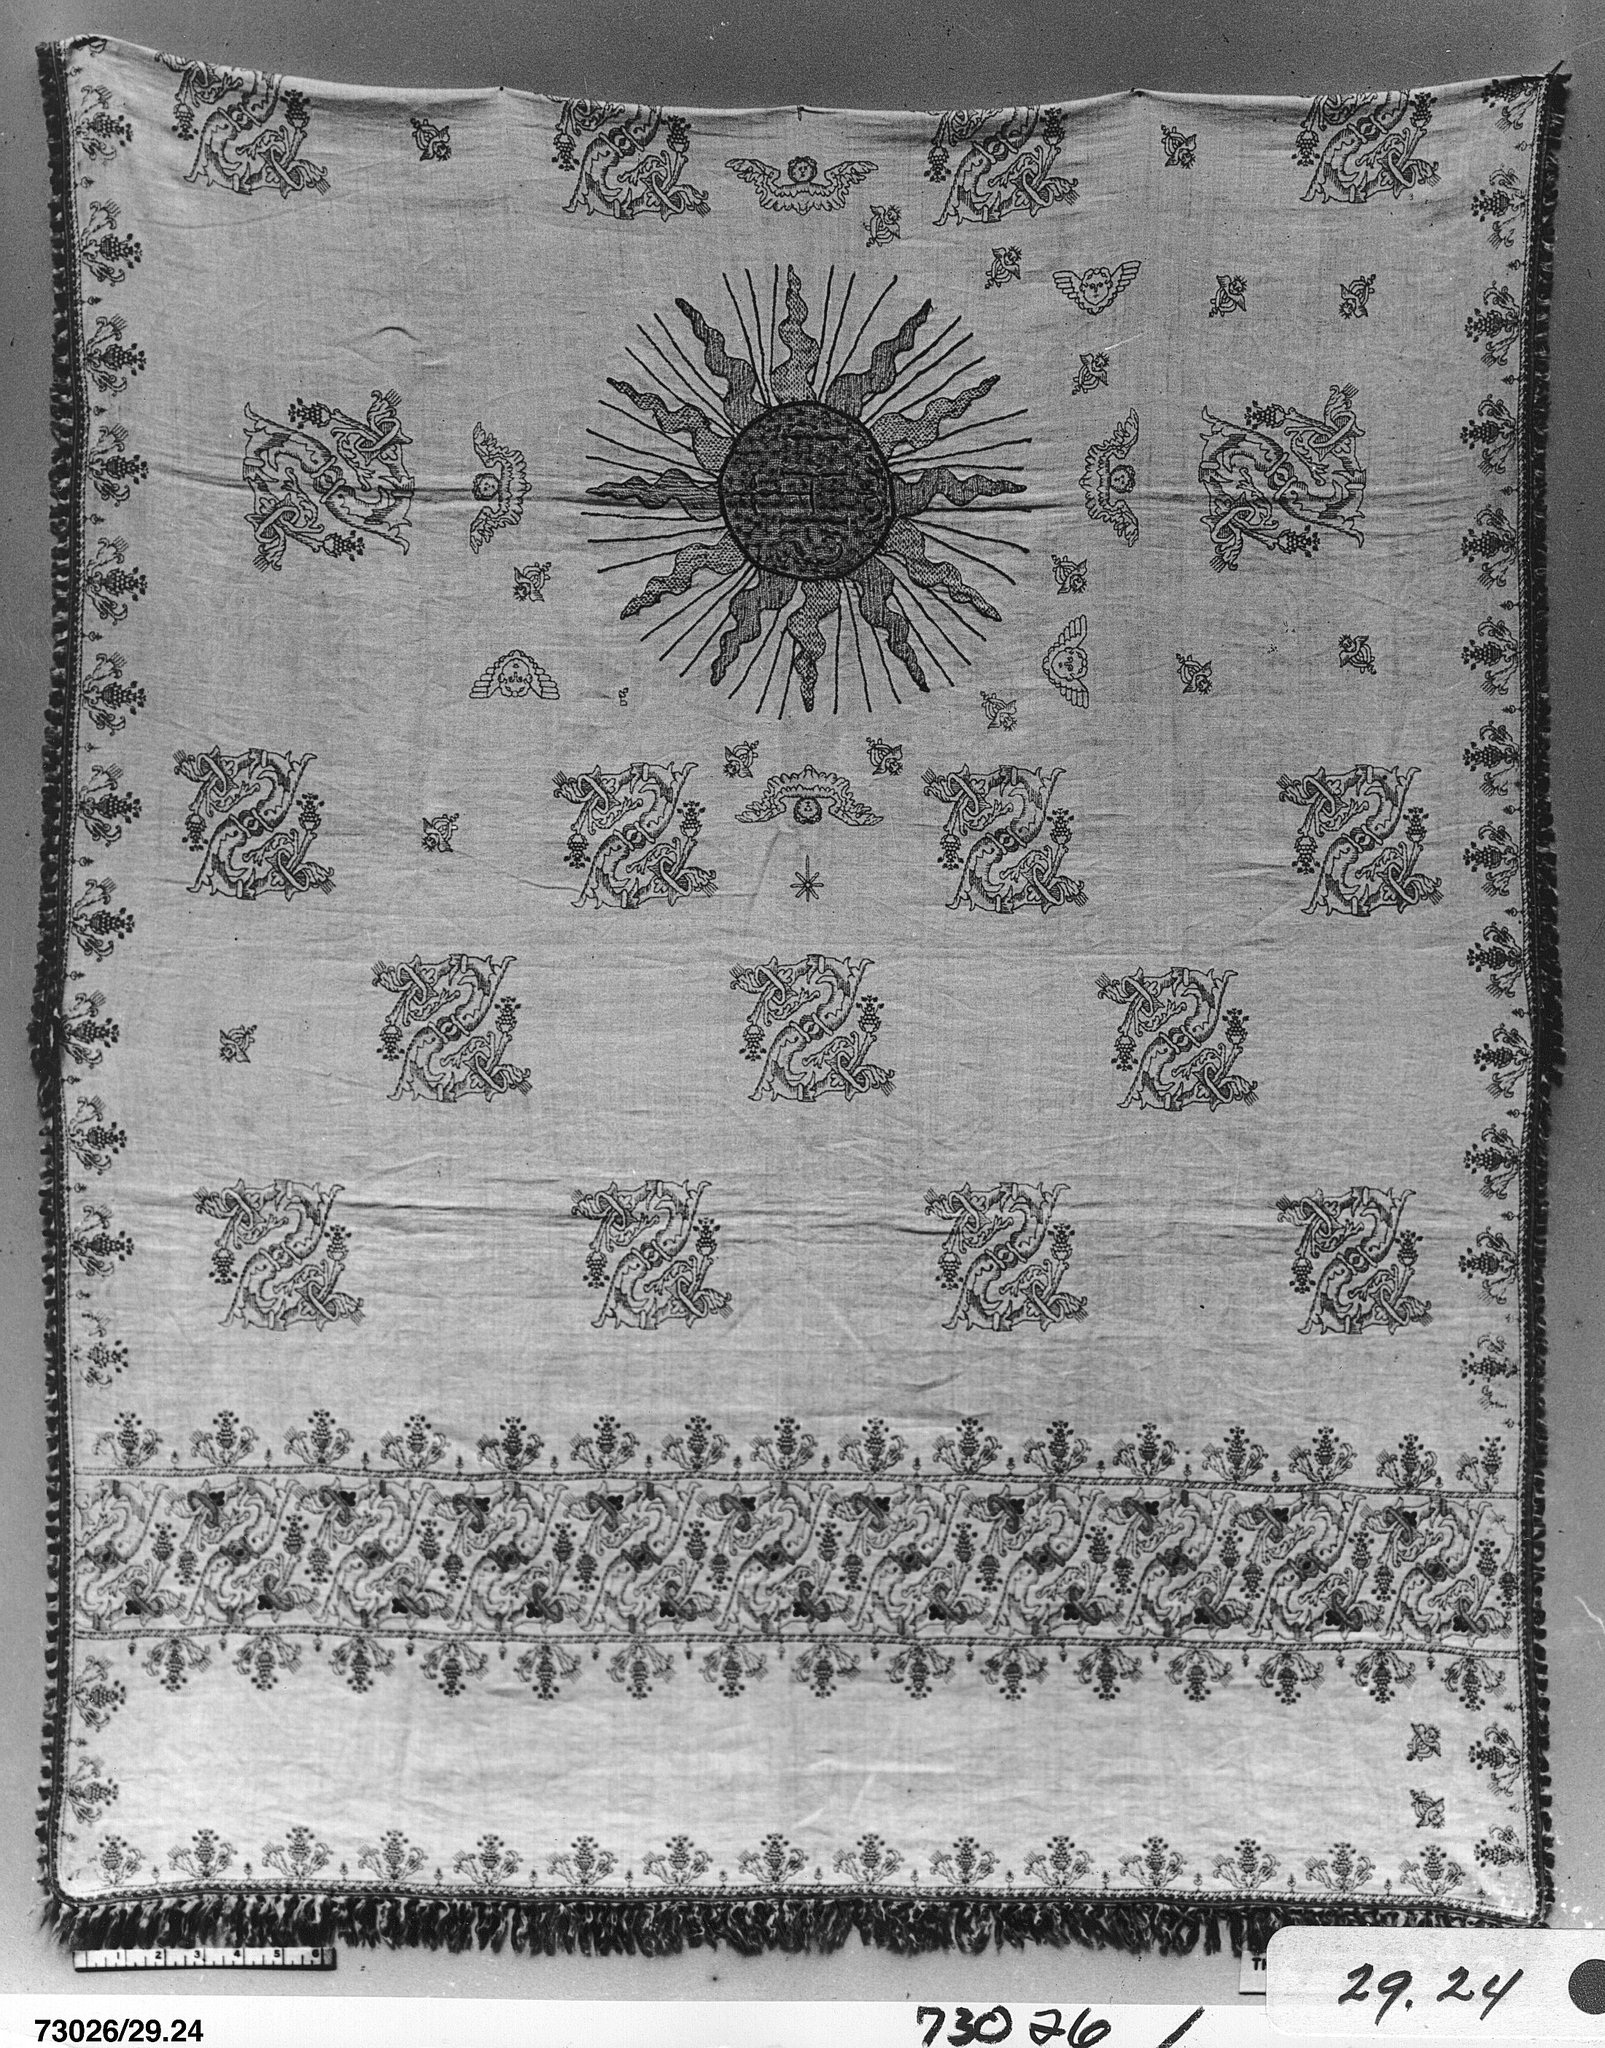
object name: altar cloth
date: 1501-1600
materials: linen, metal thread, silk